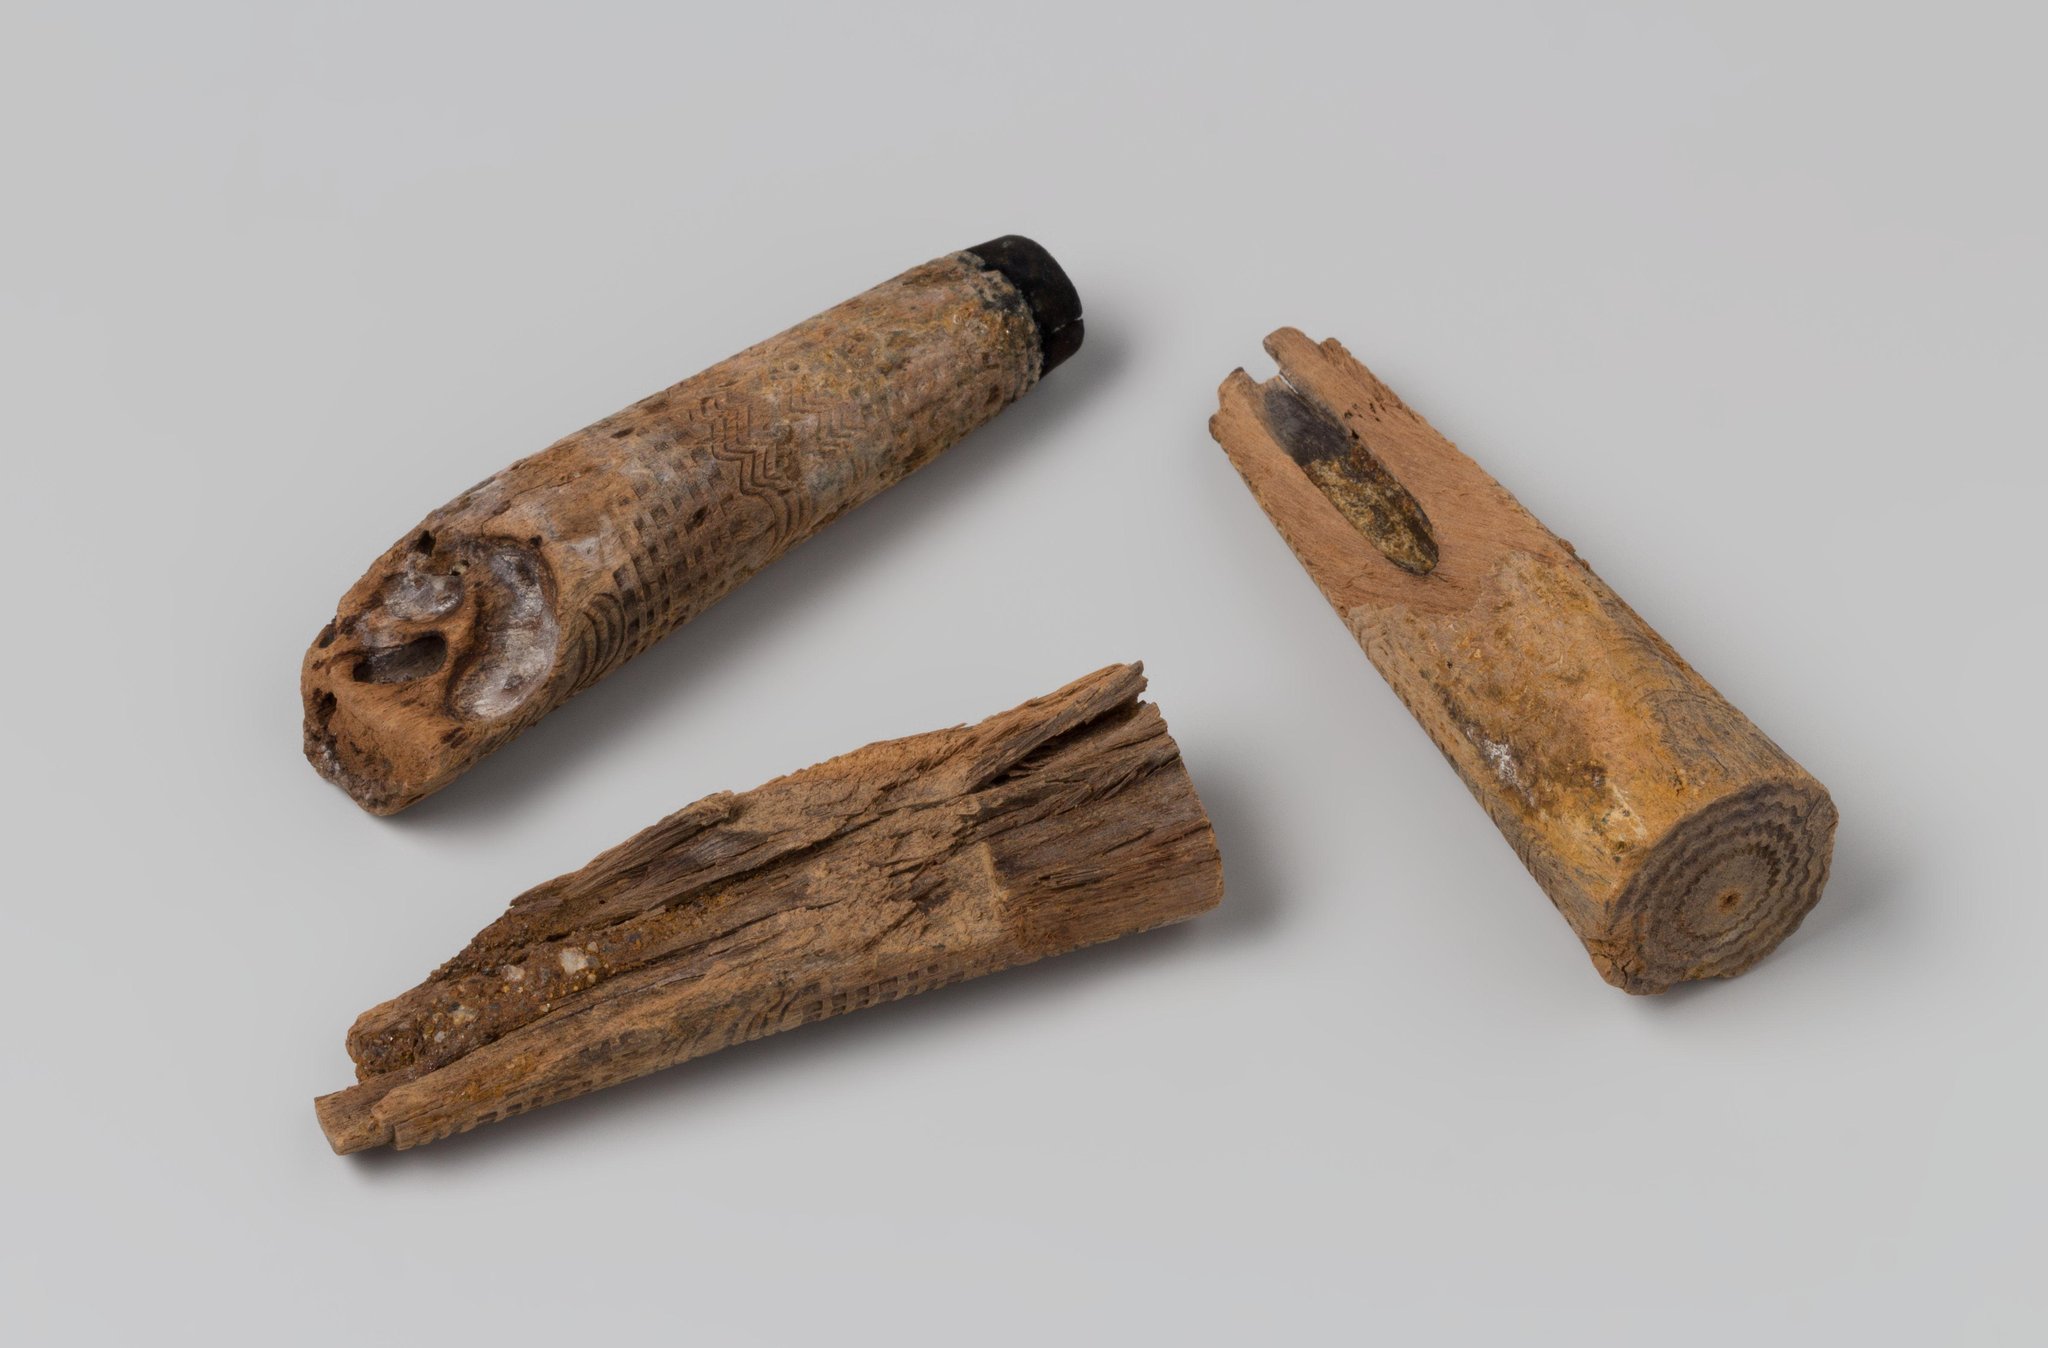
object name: knife handle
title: Messenheften uit het wrak van de Oost-Indiëvaarder Hollandia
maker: Anonymous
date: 1700-1743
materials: copper, wood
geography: netherlands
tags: verenigde oostindische compagnie, hollandia (schip), annet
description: Knife, handle, cylindrical: tapering; id. NG 1979-403H, ferrule, id. NG 1980-27H426.